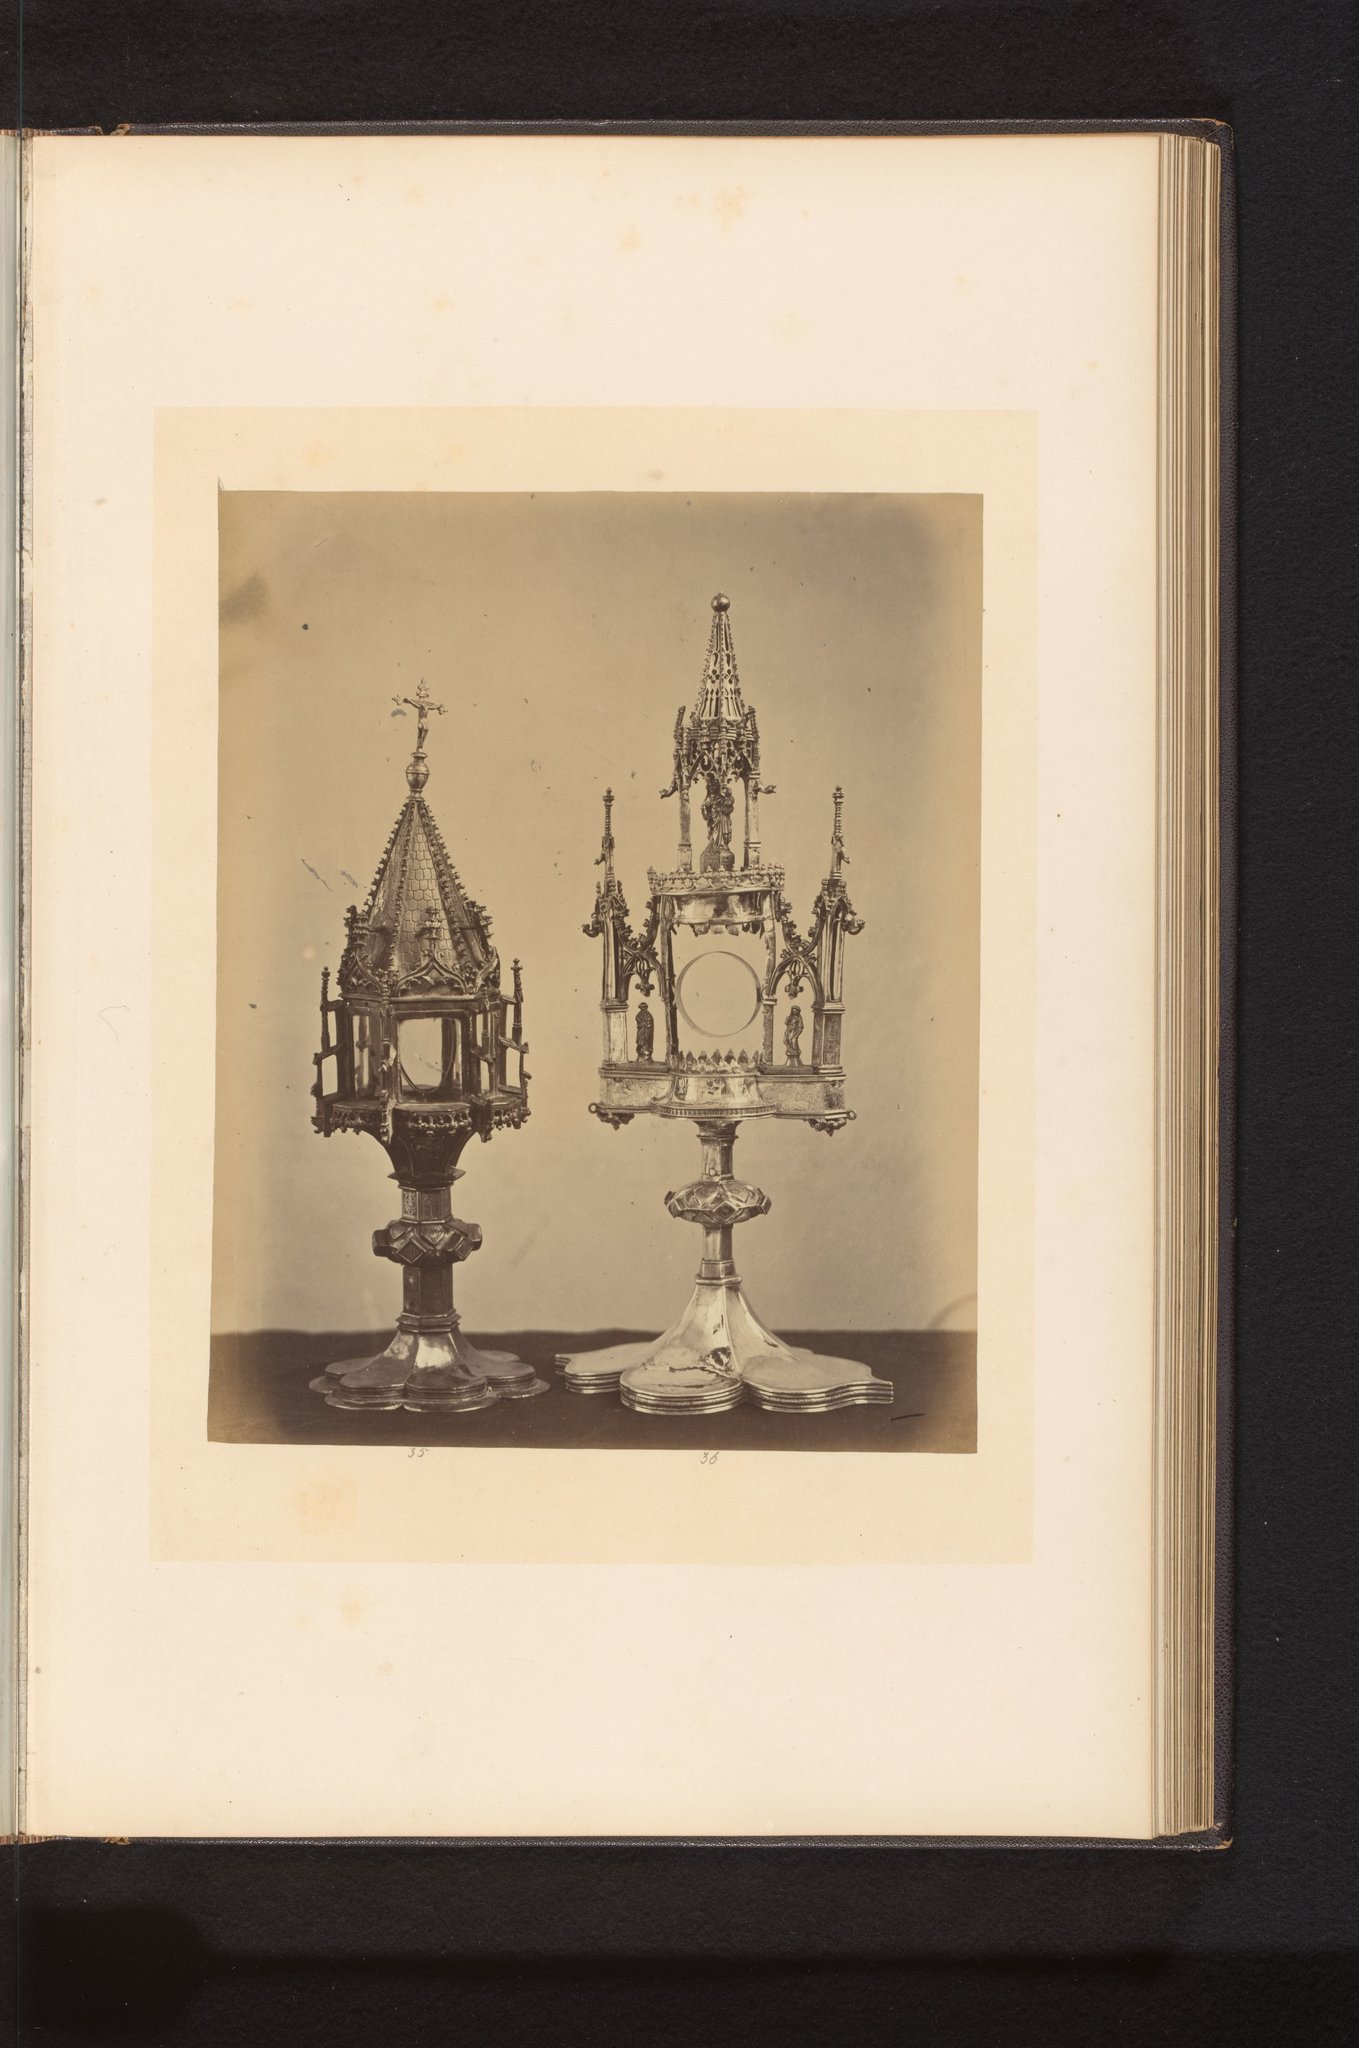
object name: photograph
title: Twee vergulde monstransen, opgesteld op een tentoonstelling over religieuze objecten uit de middeleeuwen en renaissance in 1864 in Mechelen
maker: joseph maes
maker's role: fotograaf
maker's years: 1838-1908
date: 1864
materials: photographic support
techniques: albumen print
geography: mechelen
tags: ostensorium, monstrance, mechelen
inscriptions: number: ‘35 - 36’